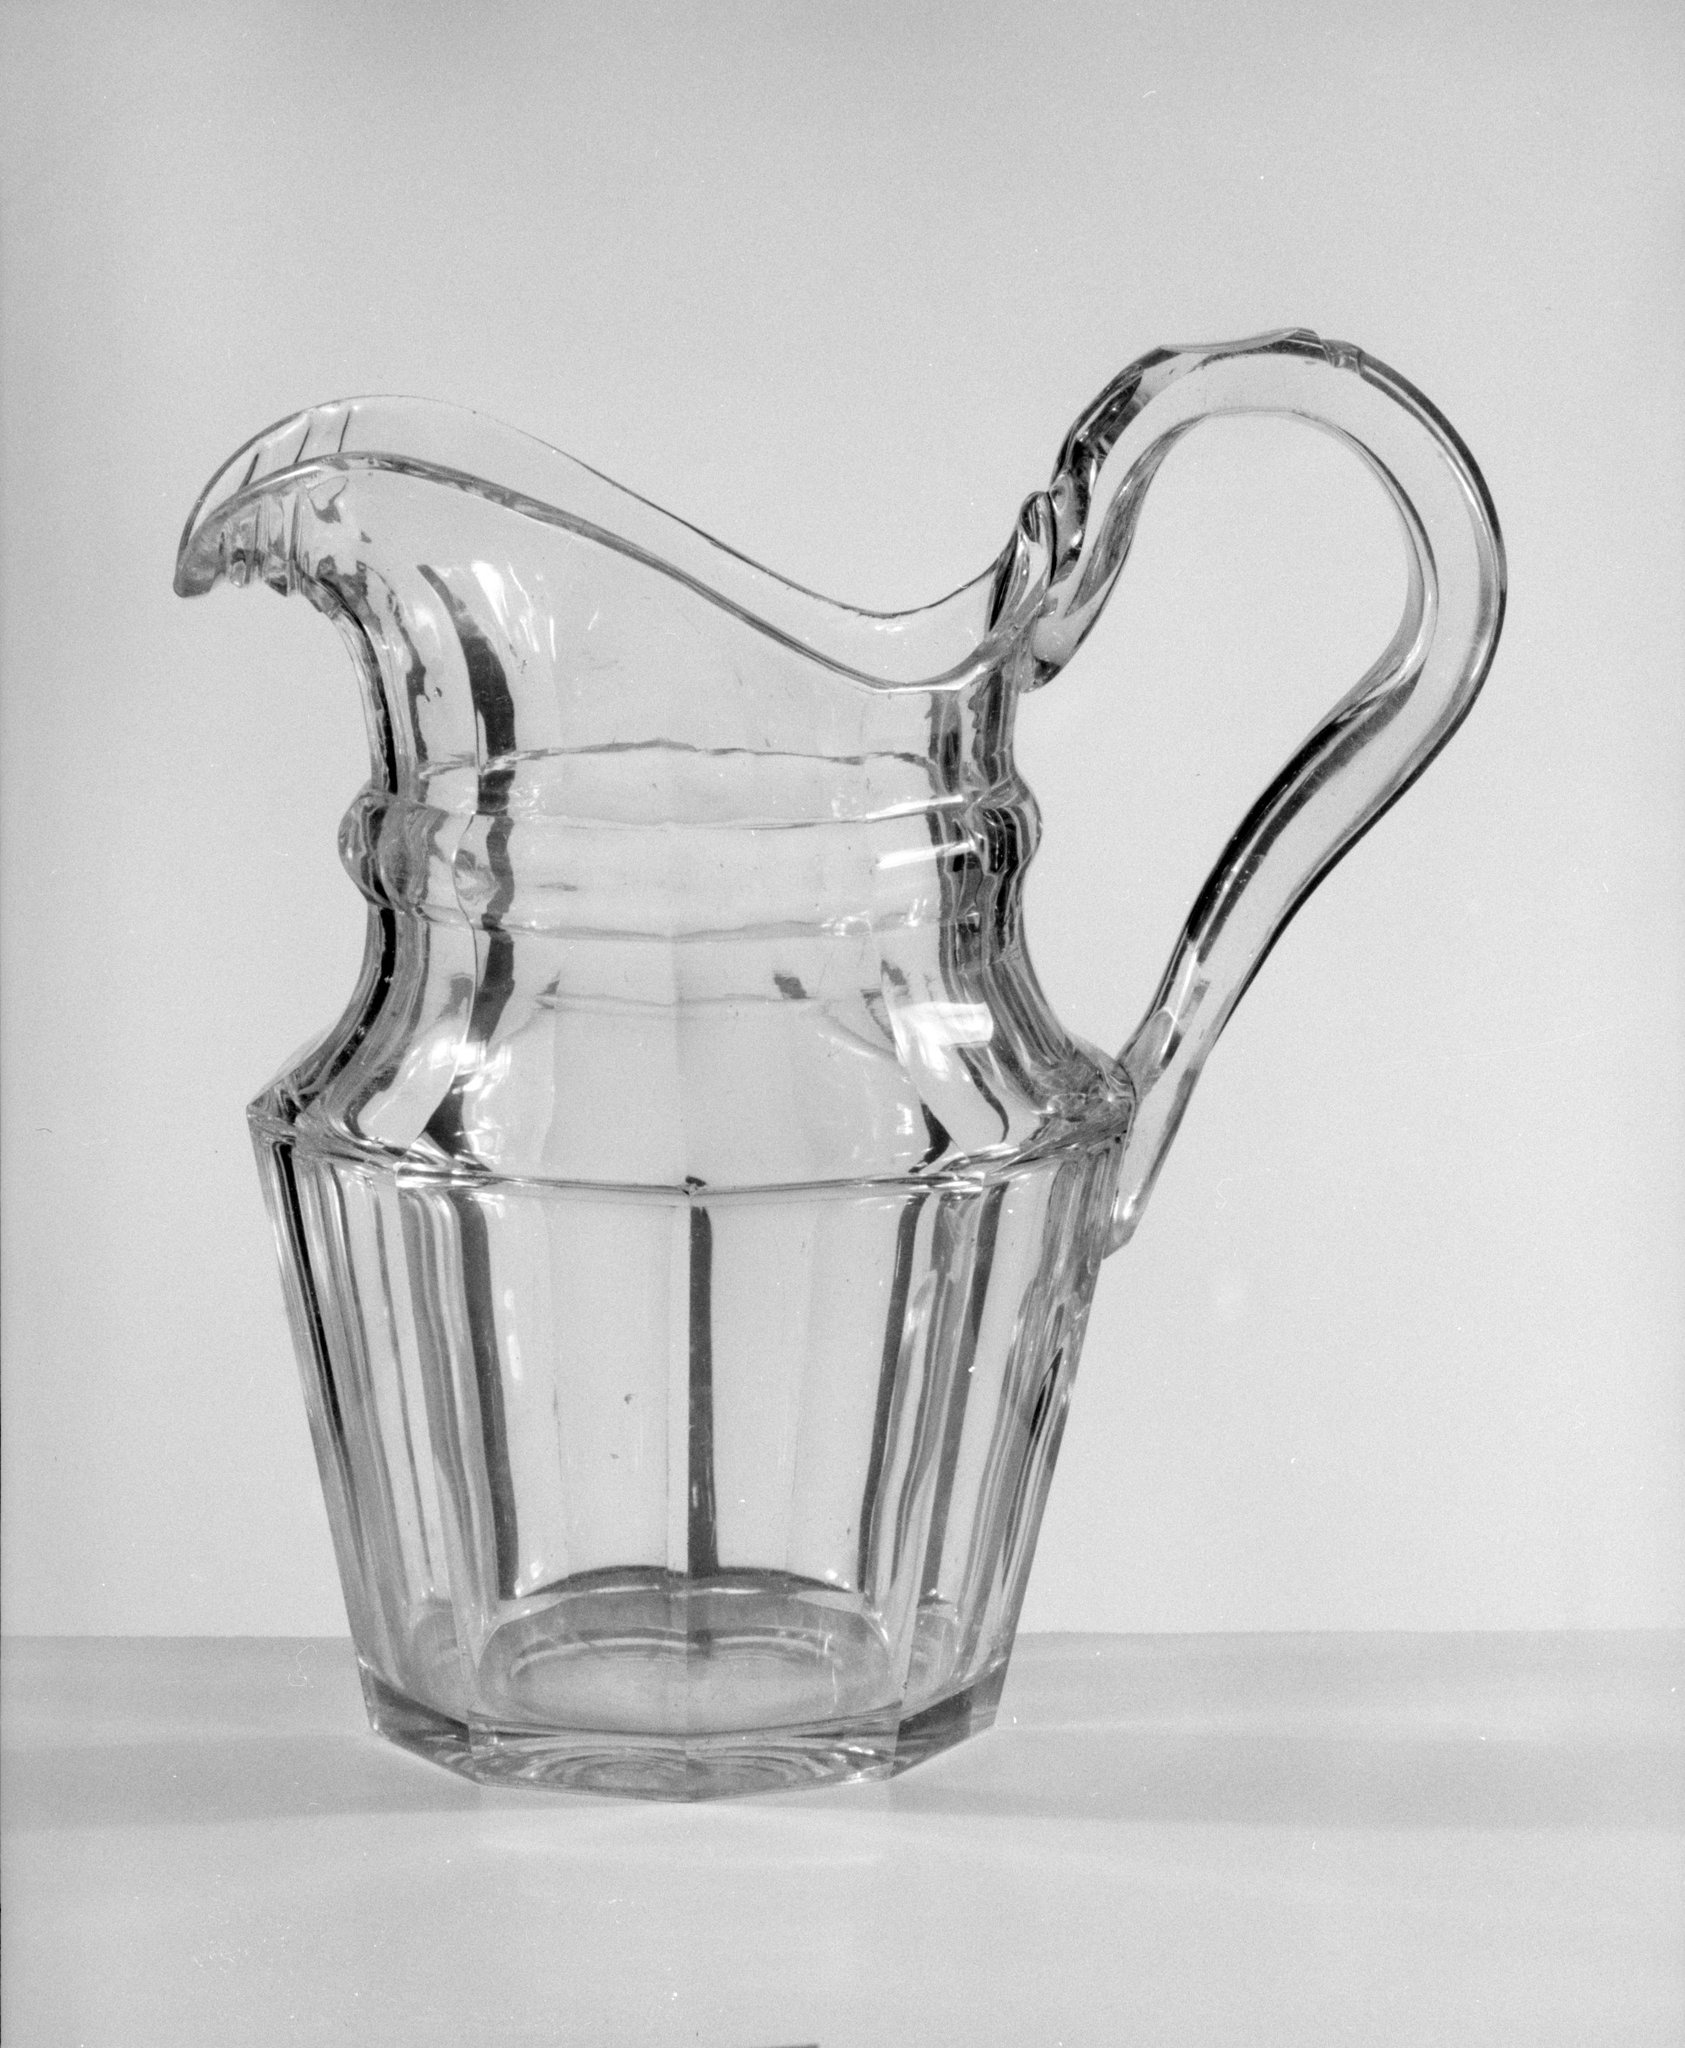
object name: pitcher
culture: american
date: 1840-1850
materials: glass, lead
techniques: glassblowing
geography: united states